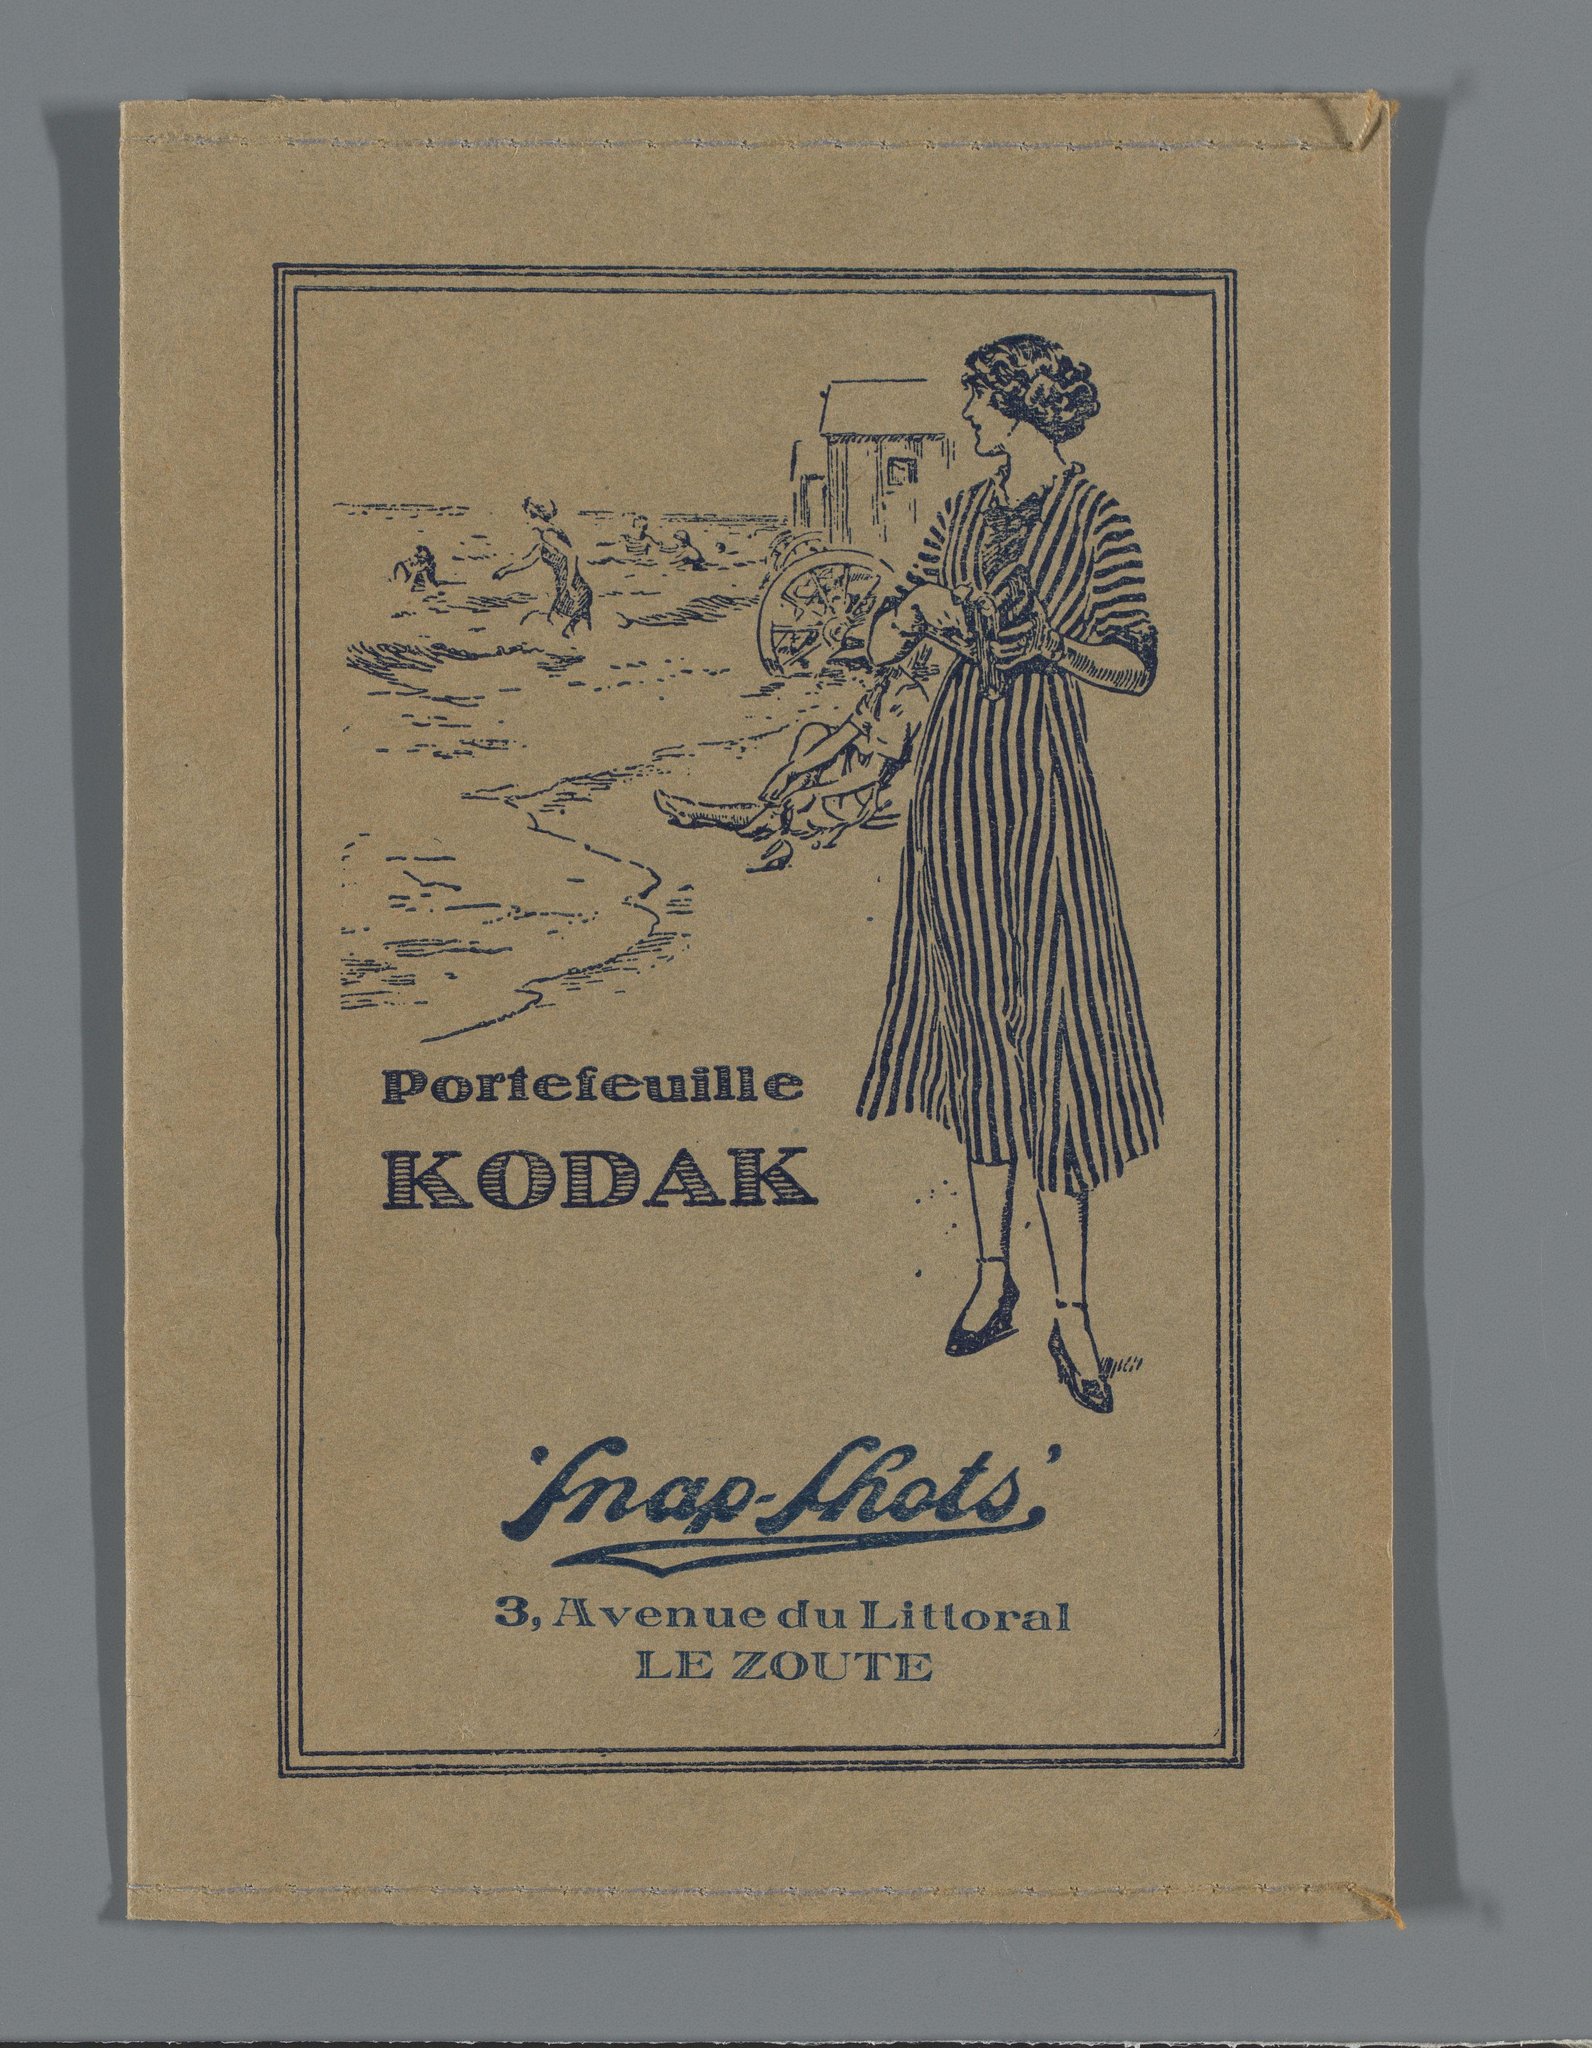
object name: photomap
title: Portefeuille Kodak "Snap-Shots"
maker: Anonymous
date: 1929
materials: ink, paper, textile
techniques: letterpress printing, pen, printing block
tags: beach (as place of recreation), camera ~ photography, taking photographs - cc - out of doors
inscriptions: address: ‘3, Avenue du Littoral/ Le Zoute’, inscription: ‘huwelijk Jon & Nees/ feest Bergen, 1929.’, inscription: ‘7/12 2057/ 8,50’